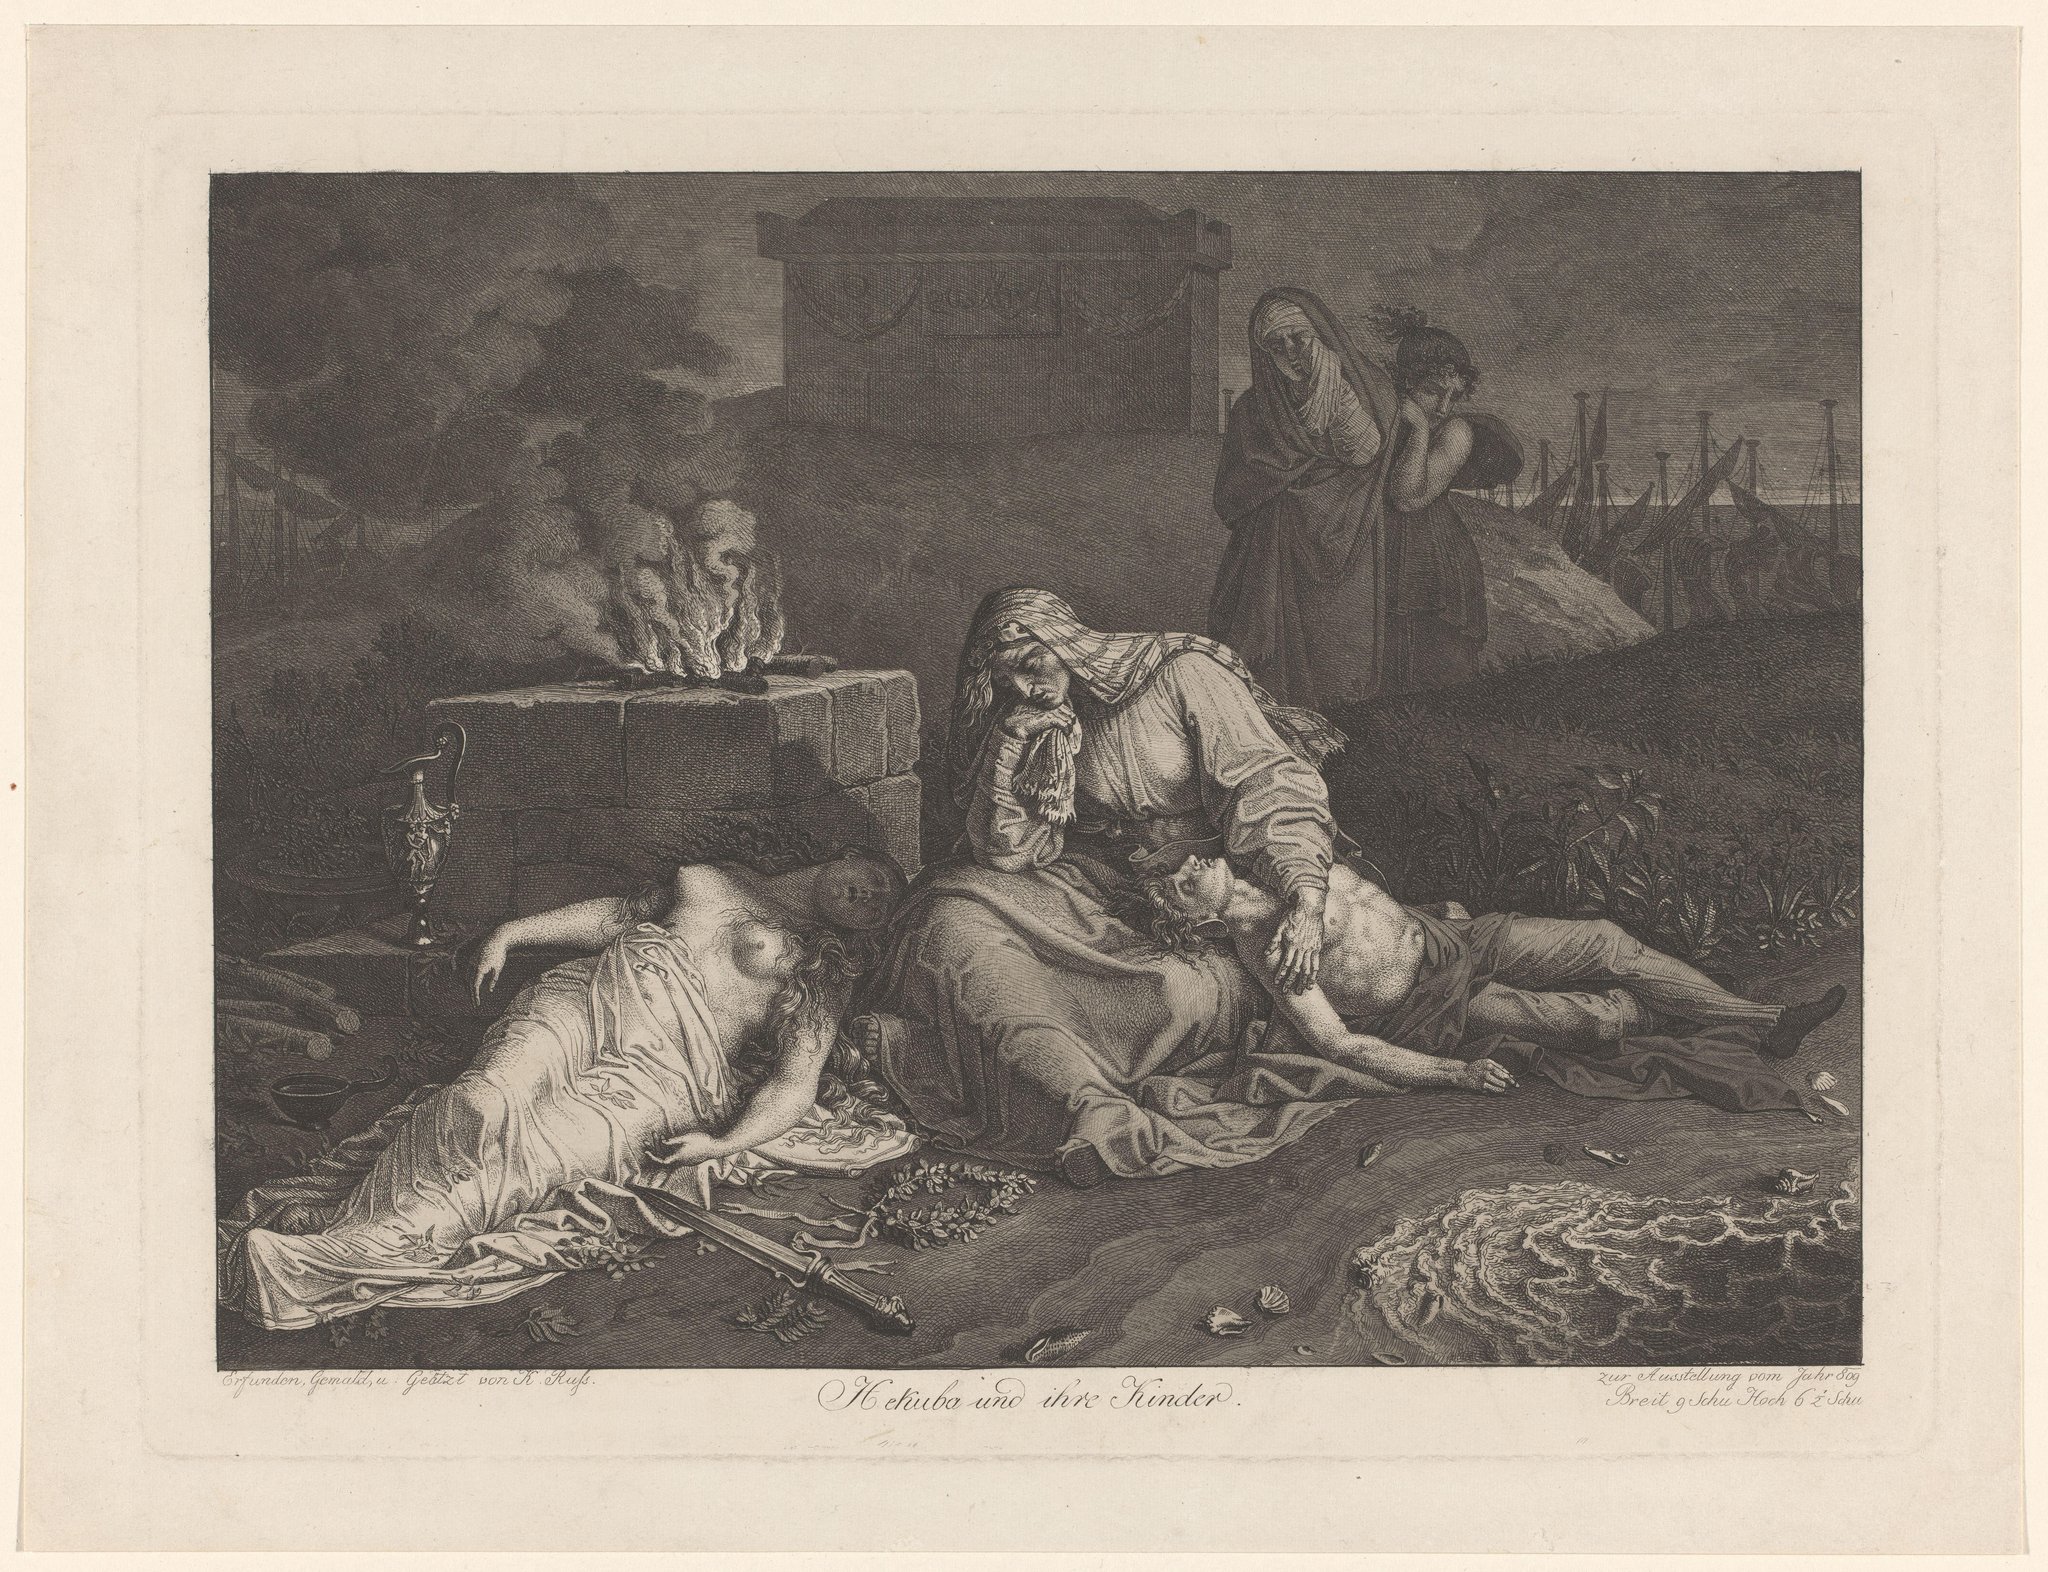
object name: print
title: Hekuba und ihre Kinder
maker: karl russ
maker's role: print maker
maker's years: 1779-1843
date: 1809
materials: paper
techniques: aquatint, etching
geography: vienna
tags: hecuba finds her dead son polydorus on the sea-shore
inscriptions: collector's mark: Lugt 2760, collector's mark: Lugt 2228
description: Naar het prijswinnende schilderij van de kunstenaar uit 1809. In de collectie van Museum Belvedere, Wenen, inventarisnummer 3729.